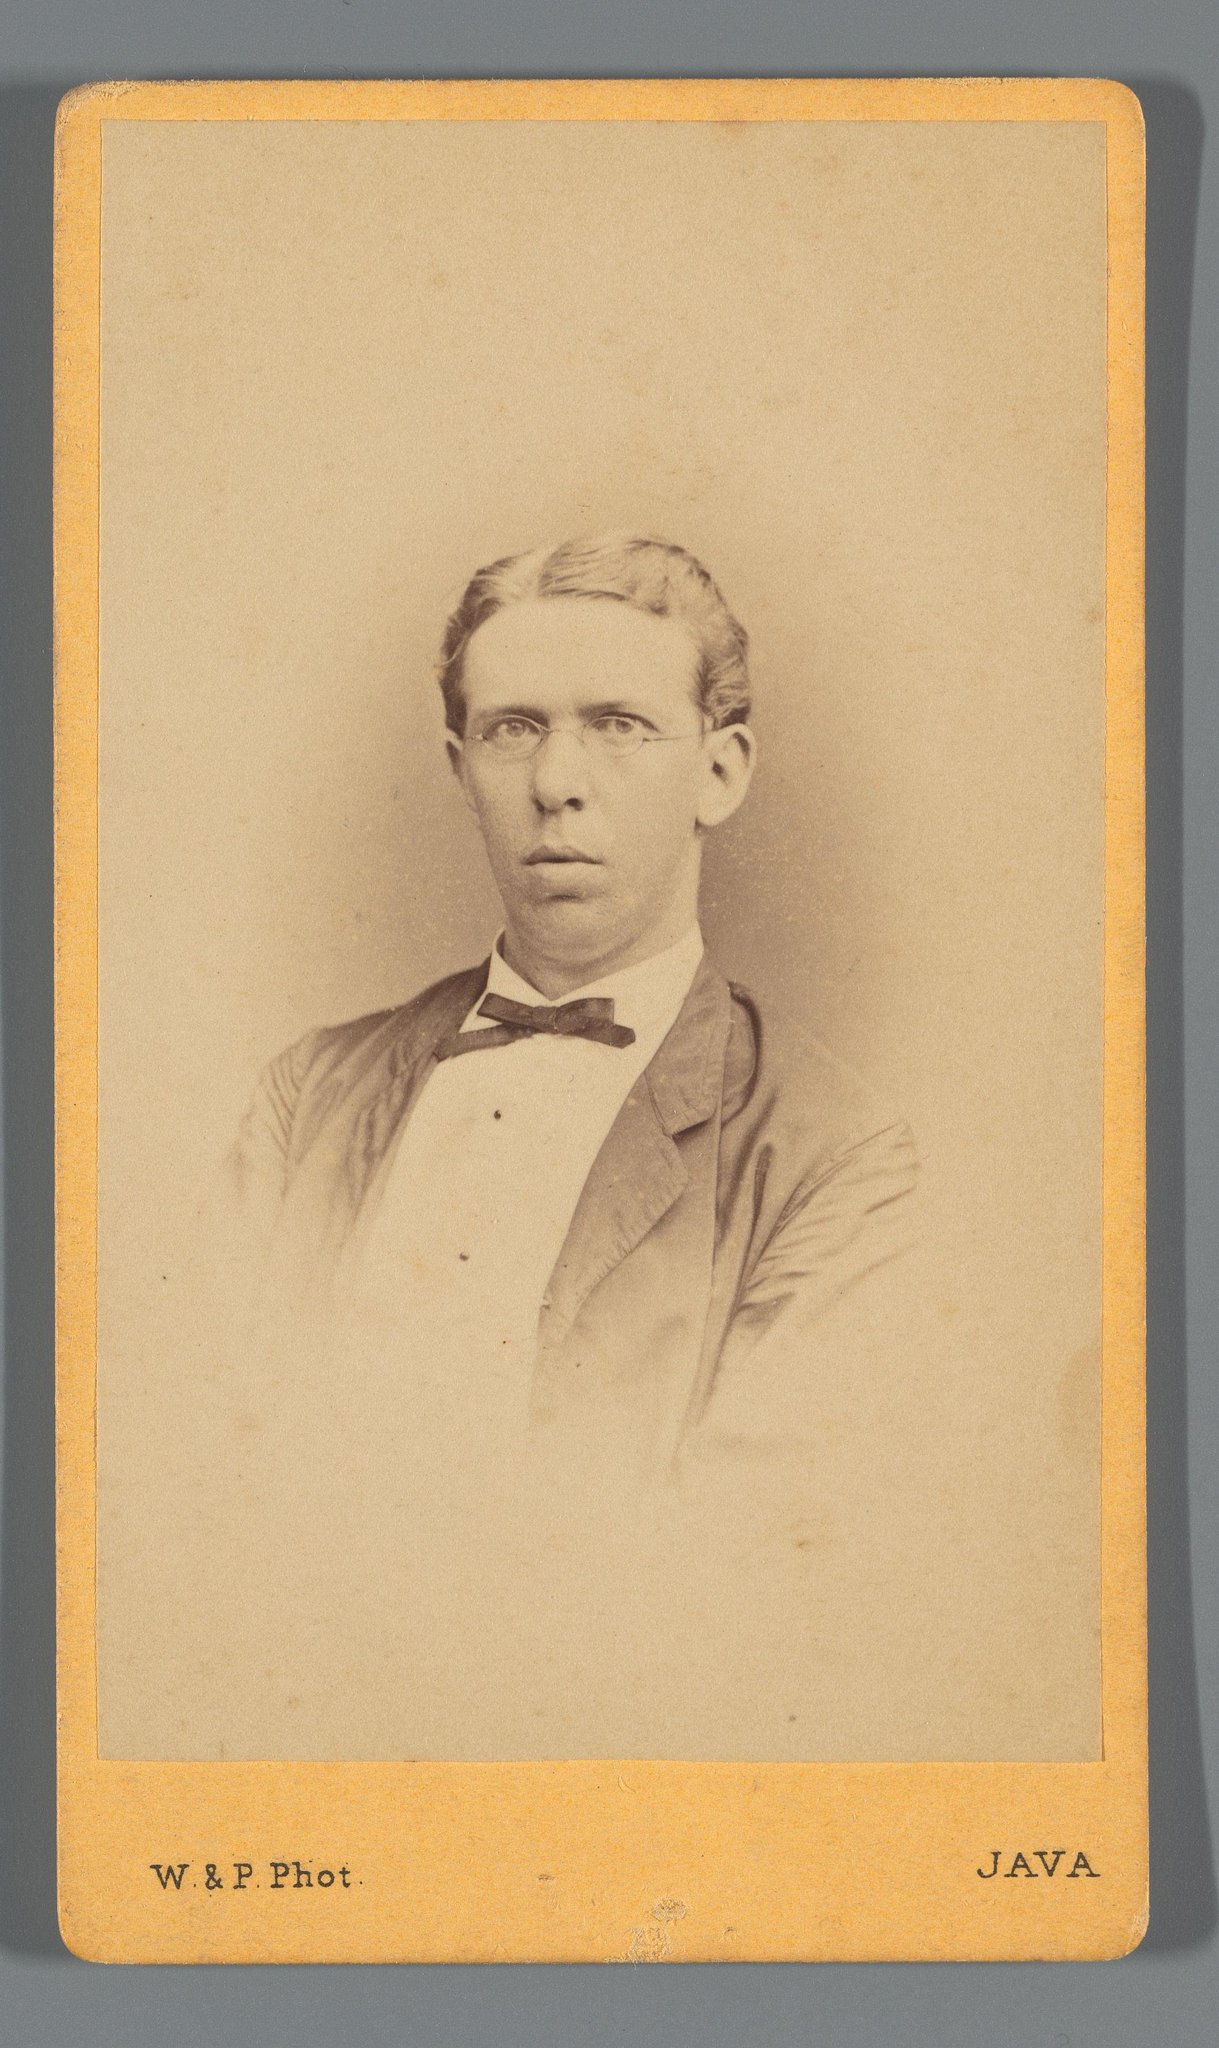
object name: carte de visite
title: Portret van Henricus Petrus Joannes van den Berg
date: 1860-1880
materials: cardboard, photographic support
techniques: albumen print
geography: java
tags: rotterdam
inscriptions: name: ‘H.P.J. v. d. Berg’, name: ‘W.&P. Phot. JAVA’, name: ‘WOODBURY & PAGE, / PHOTOGRAPHERS / JAVA.’